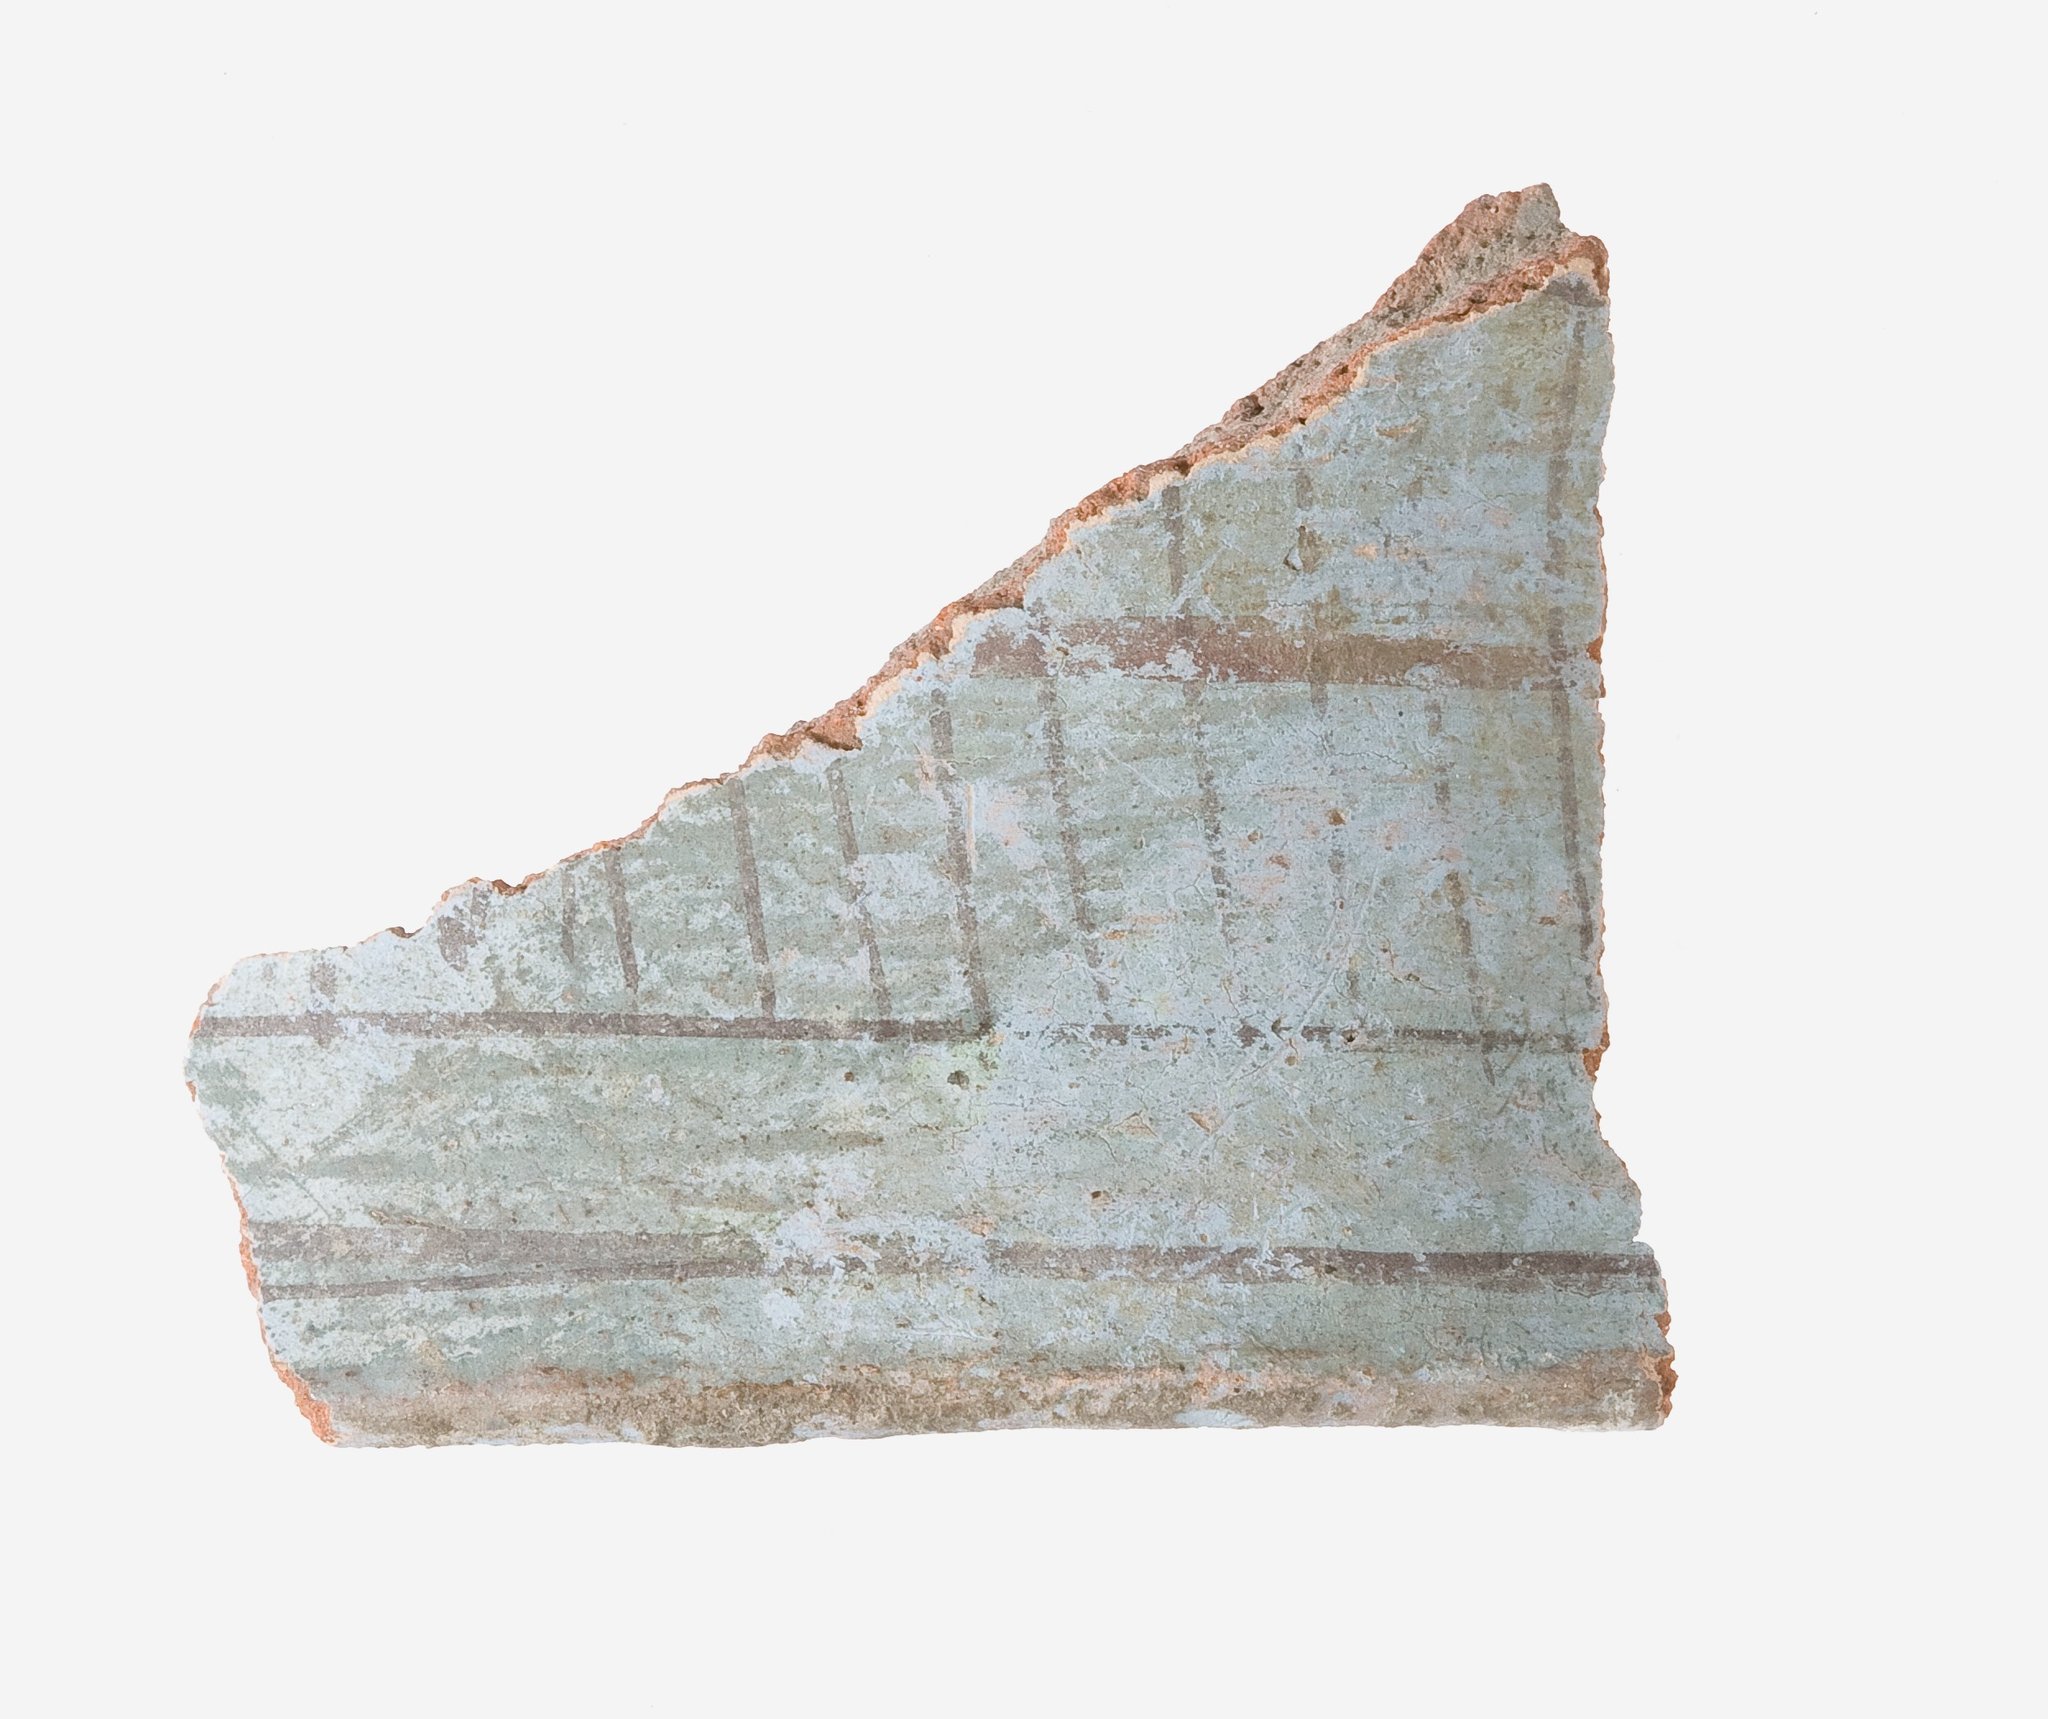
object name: vessel fragment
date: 1390-1352 BCE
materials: paint, pottery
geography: egypt